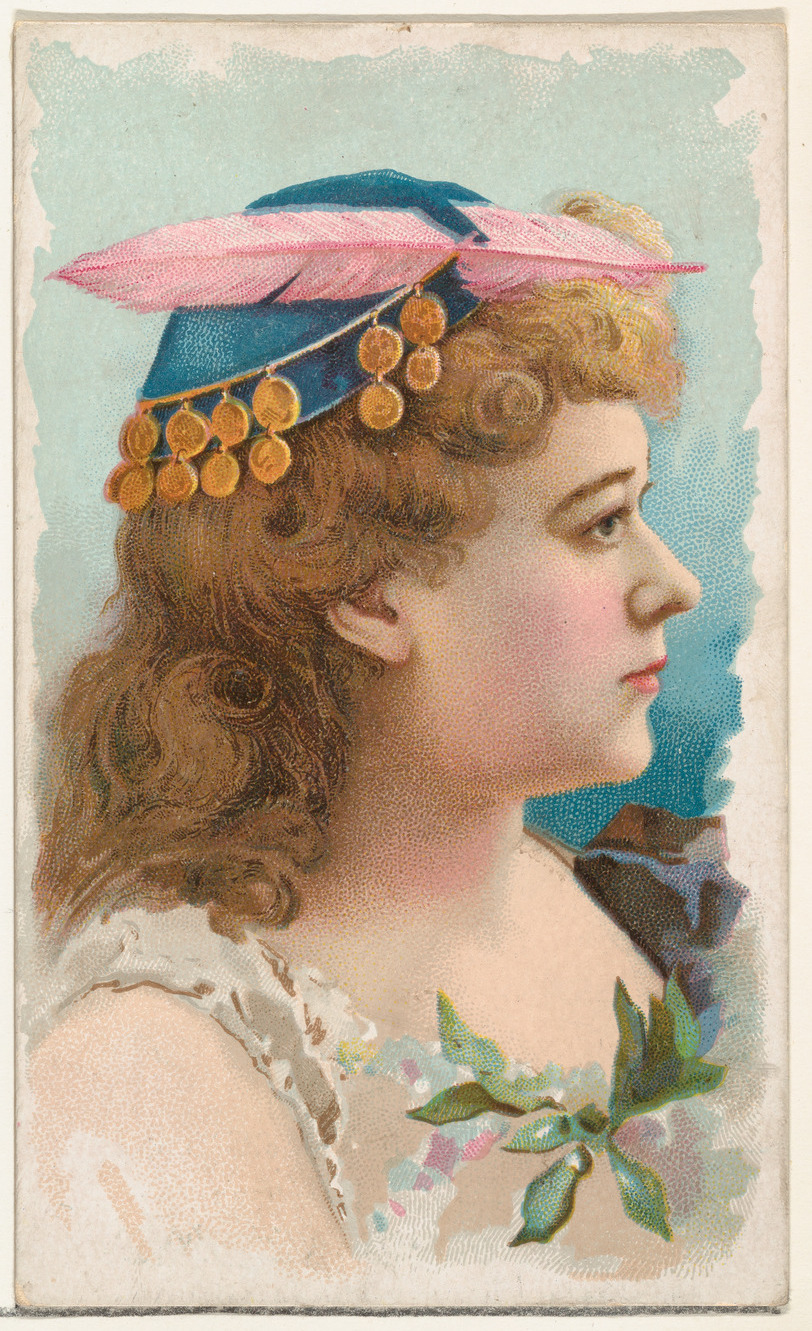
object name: print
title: Actress wearing blue cap with pink feather, from Stars of the Stage, First Series (N129) issued by W. Duke, Sons & Co. to promote Honest Long Cut Tobacco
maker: w. duke, sons & co.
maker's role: publisher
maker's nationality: american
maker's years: 1870-1920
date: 1890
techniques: color lithograph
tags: profiles,women,feathers,actresses